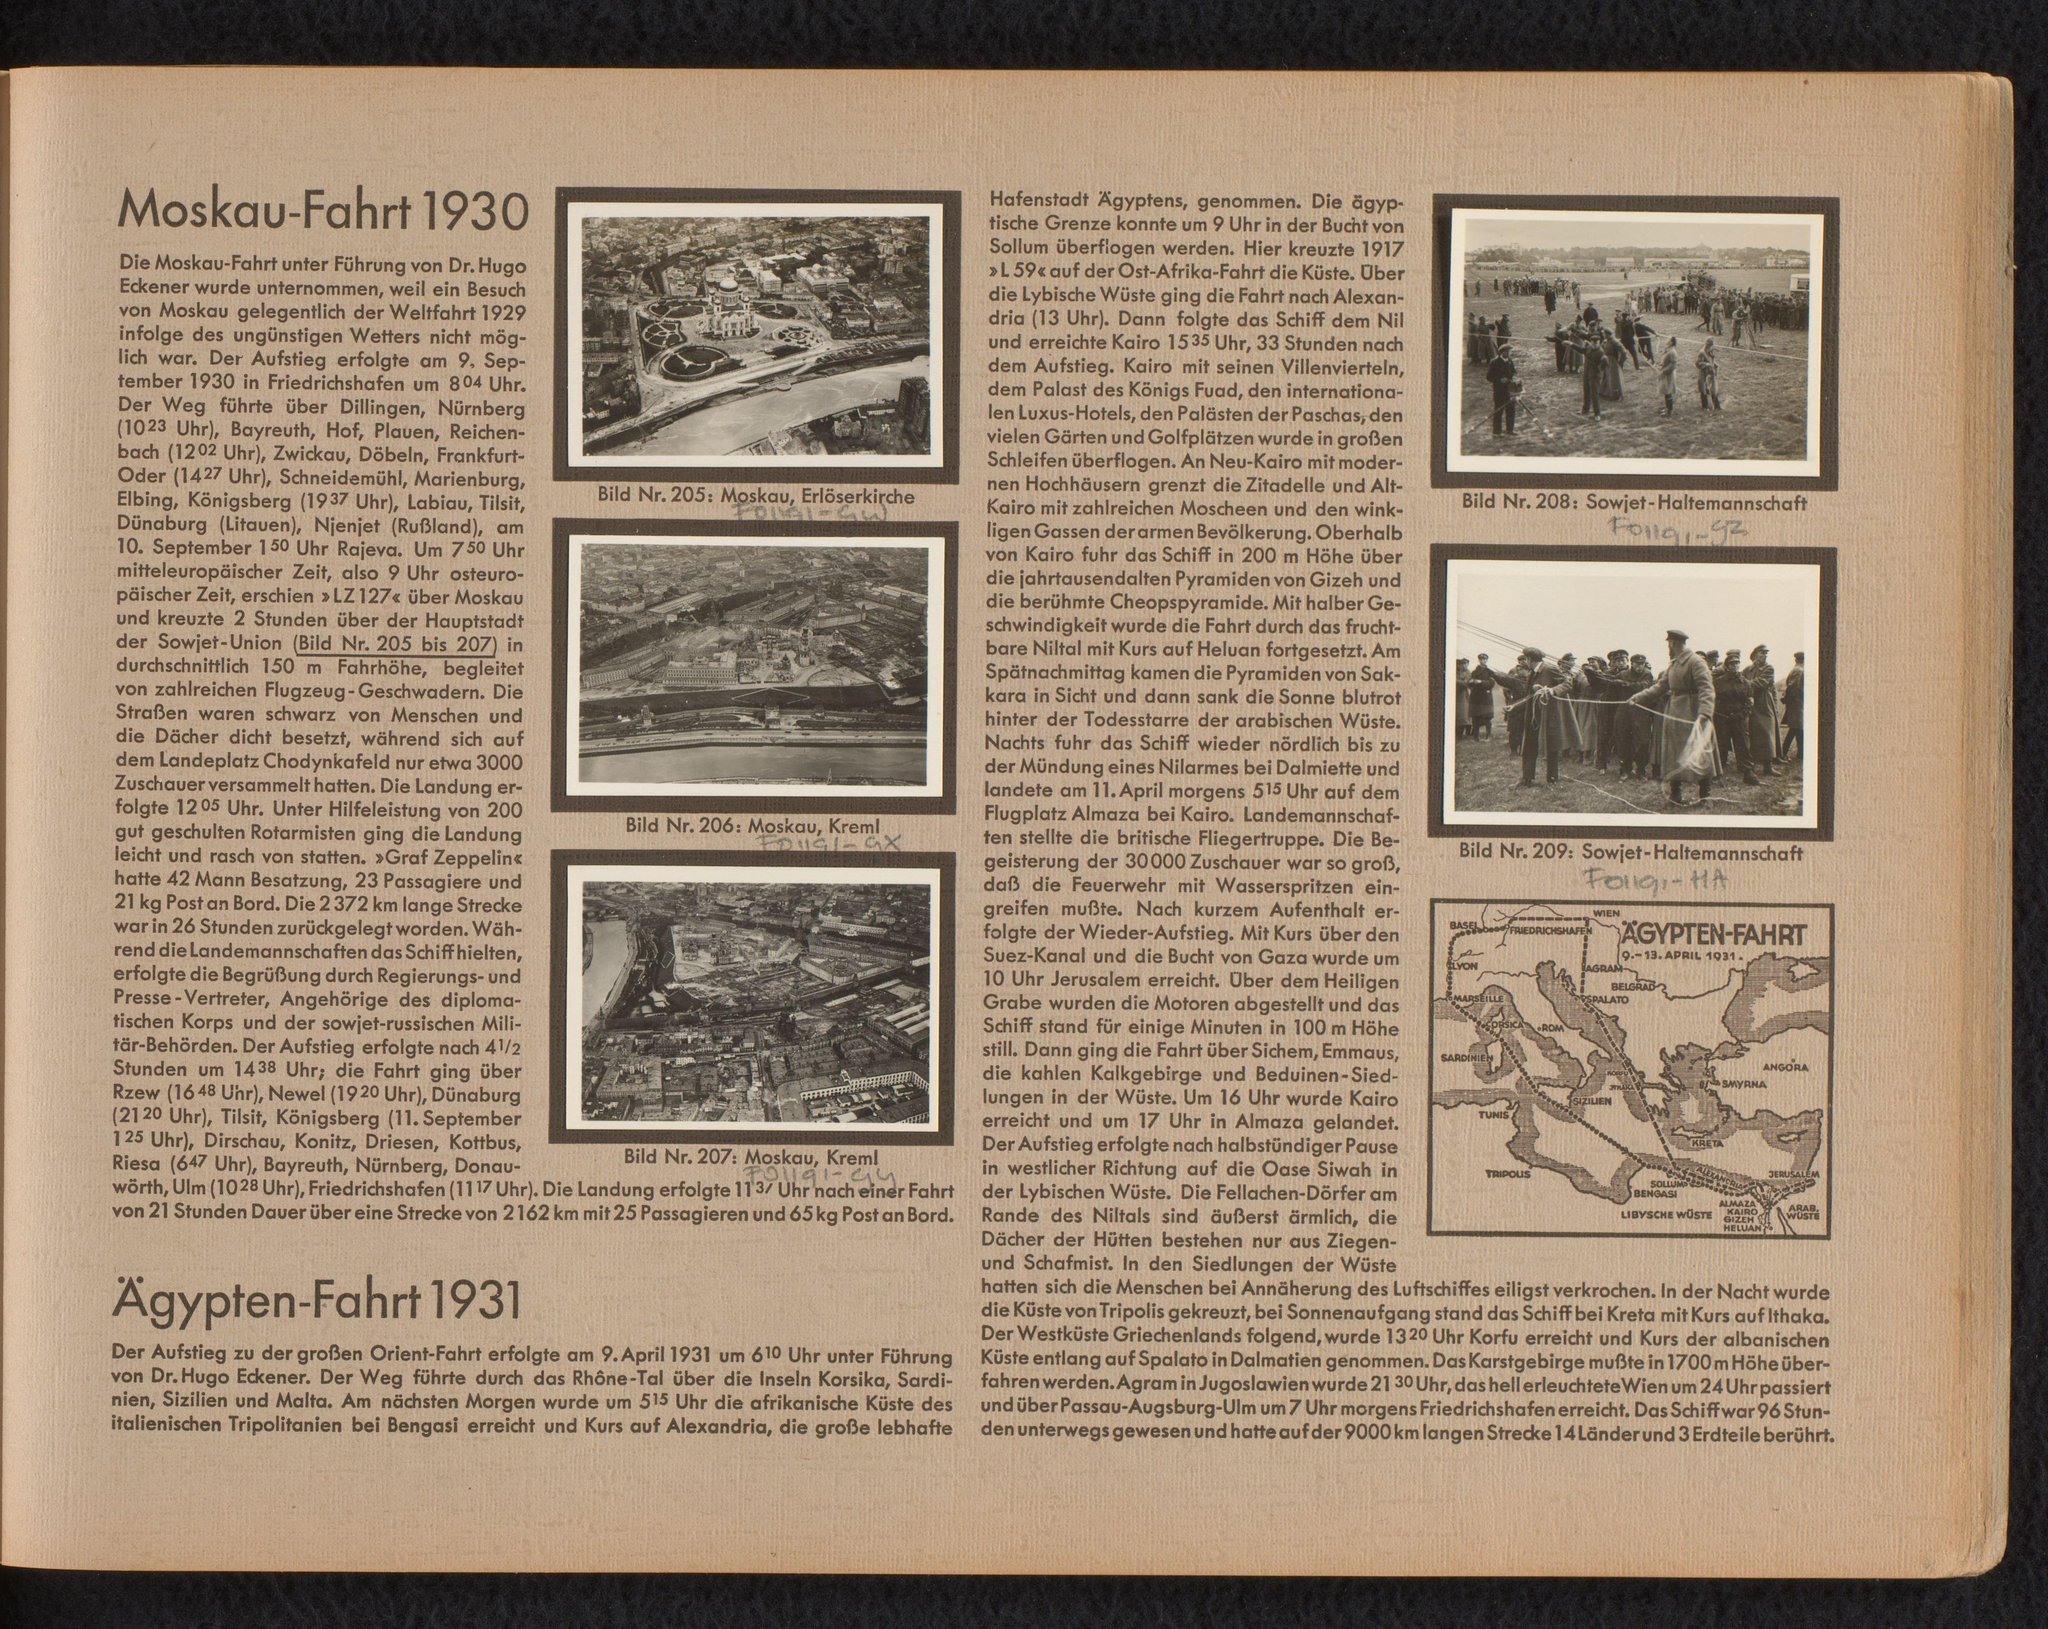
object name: album leaf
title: Uitzichten tijdens een vlucht naar Moskou door de LZ127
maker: Anonymous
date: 1930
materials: paper, photographic support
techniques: gelatin silver print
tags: city-view, and landscape with man-made constructions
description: Vijf foto's gemaakt tijdens een vlucht naar Moskou door de LZ127, waaronder gezichten op Moskou. Alle foto's zijn voorzien van een nummer en titel. Deze pagina maakt deel uit van een album.